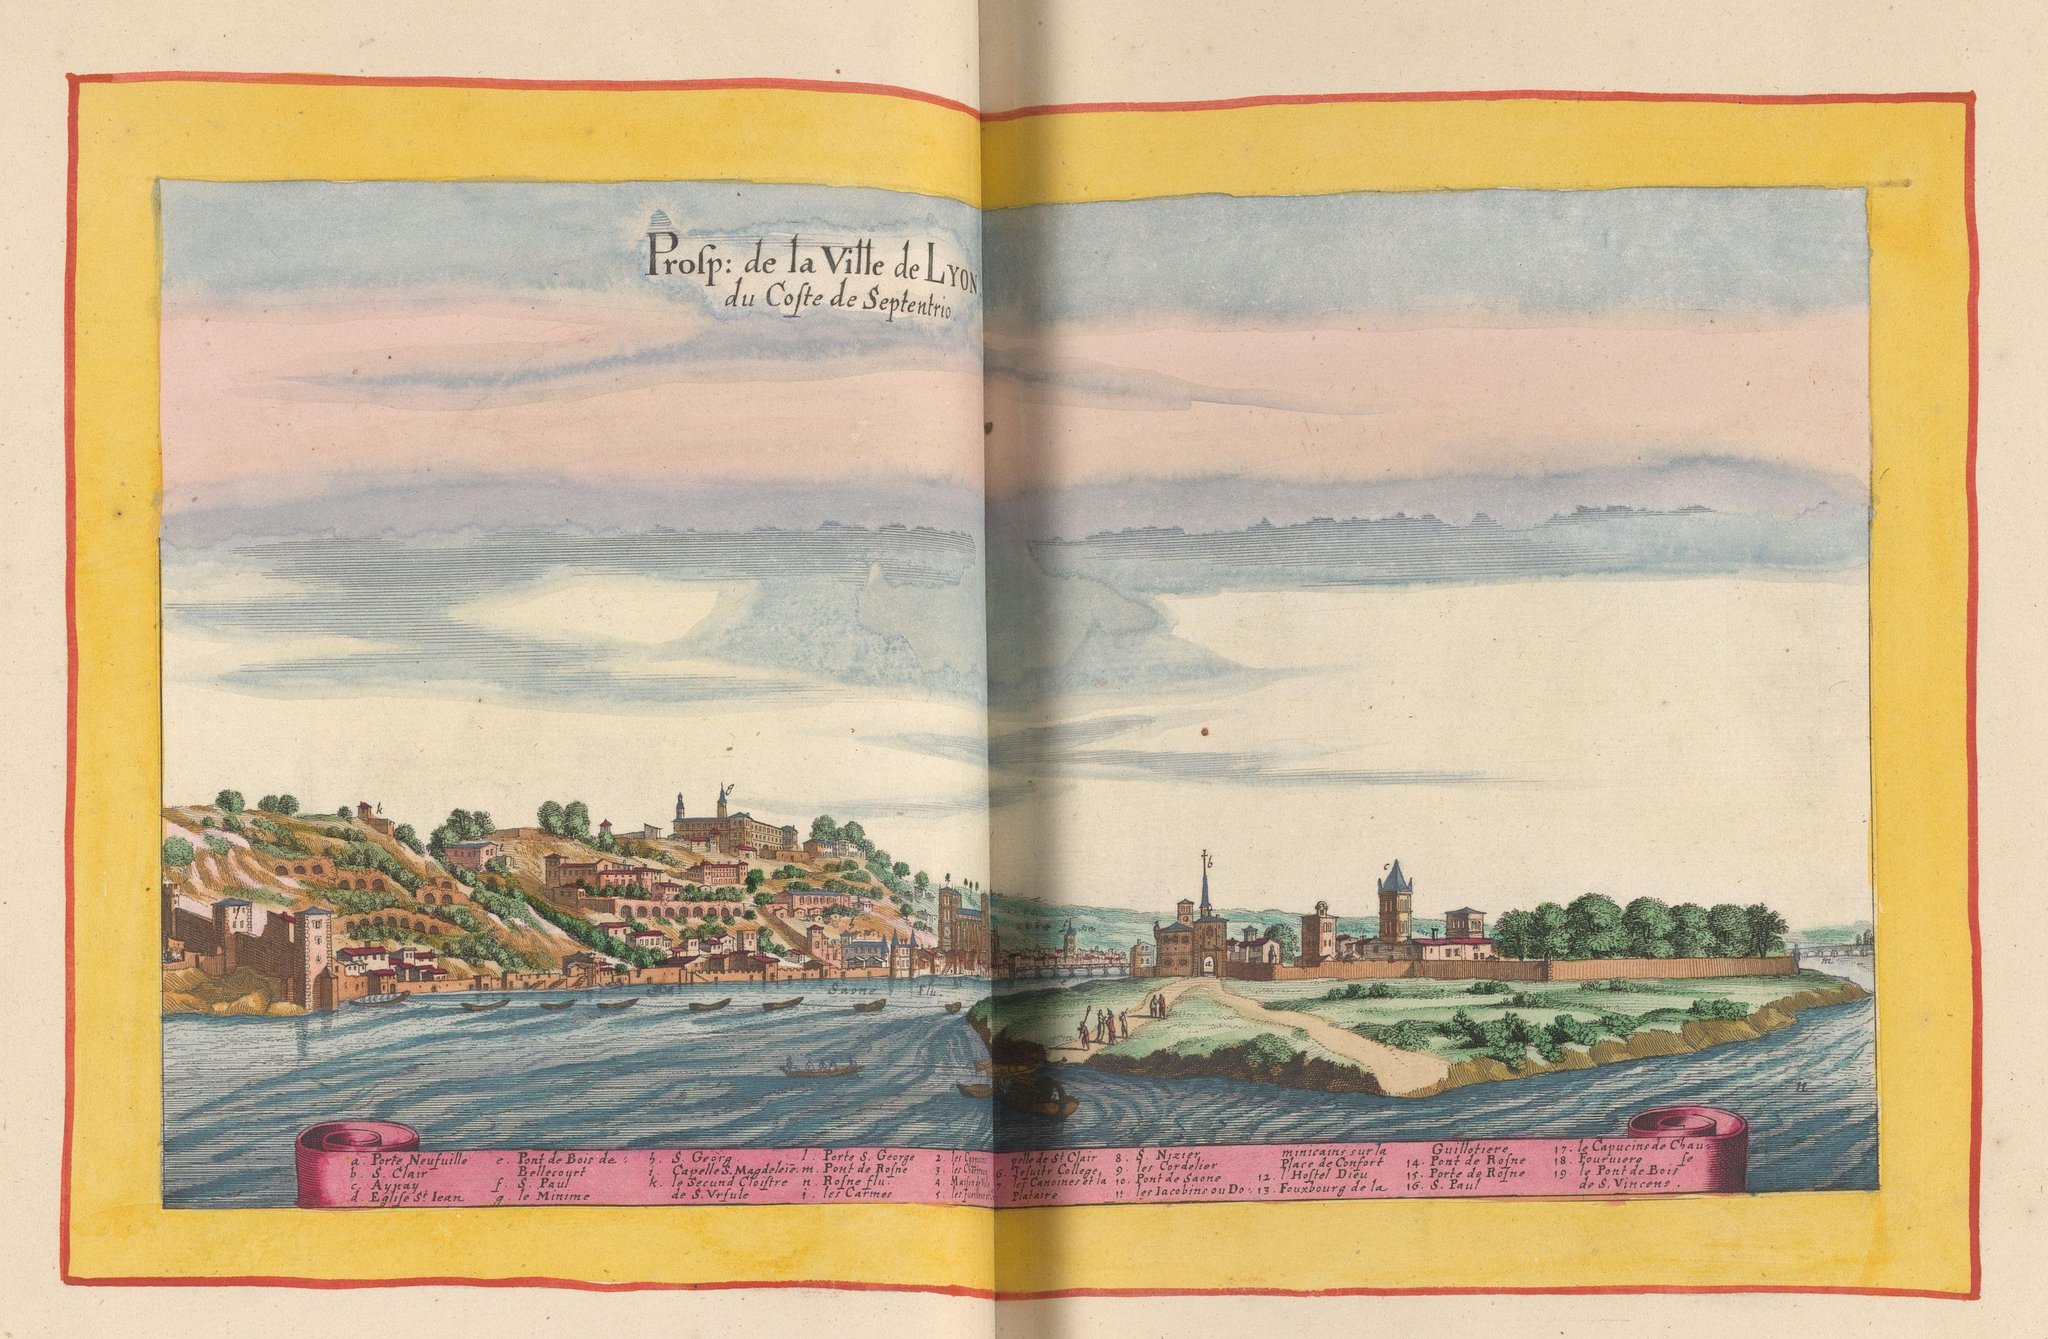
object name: print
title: Prosp. de la ville de Lyon du coste de septentrio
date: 1657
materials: paper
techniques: engraving, etching, hand coloring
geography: the hague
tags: city-view in general; 'veduta', lyon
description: Prent uit: Zeiller, Martin. Topographia Galliae. 13 dln. Frankfurt: Caspar Merian, 1657, dl. 5, na p. 10. De titel is uit de originele prent gesneden. Boven de gravure is een deel lucht en wolken (bij)geschilderd, waarin de titel gelijmd is. Origineel gedrukt op één blad met een gezicht op Lyon vanuit het zuiden (RP-P-1957-607-35-2).